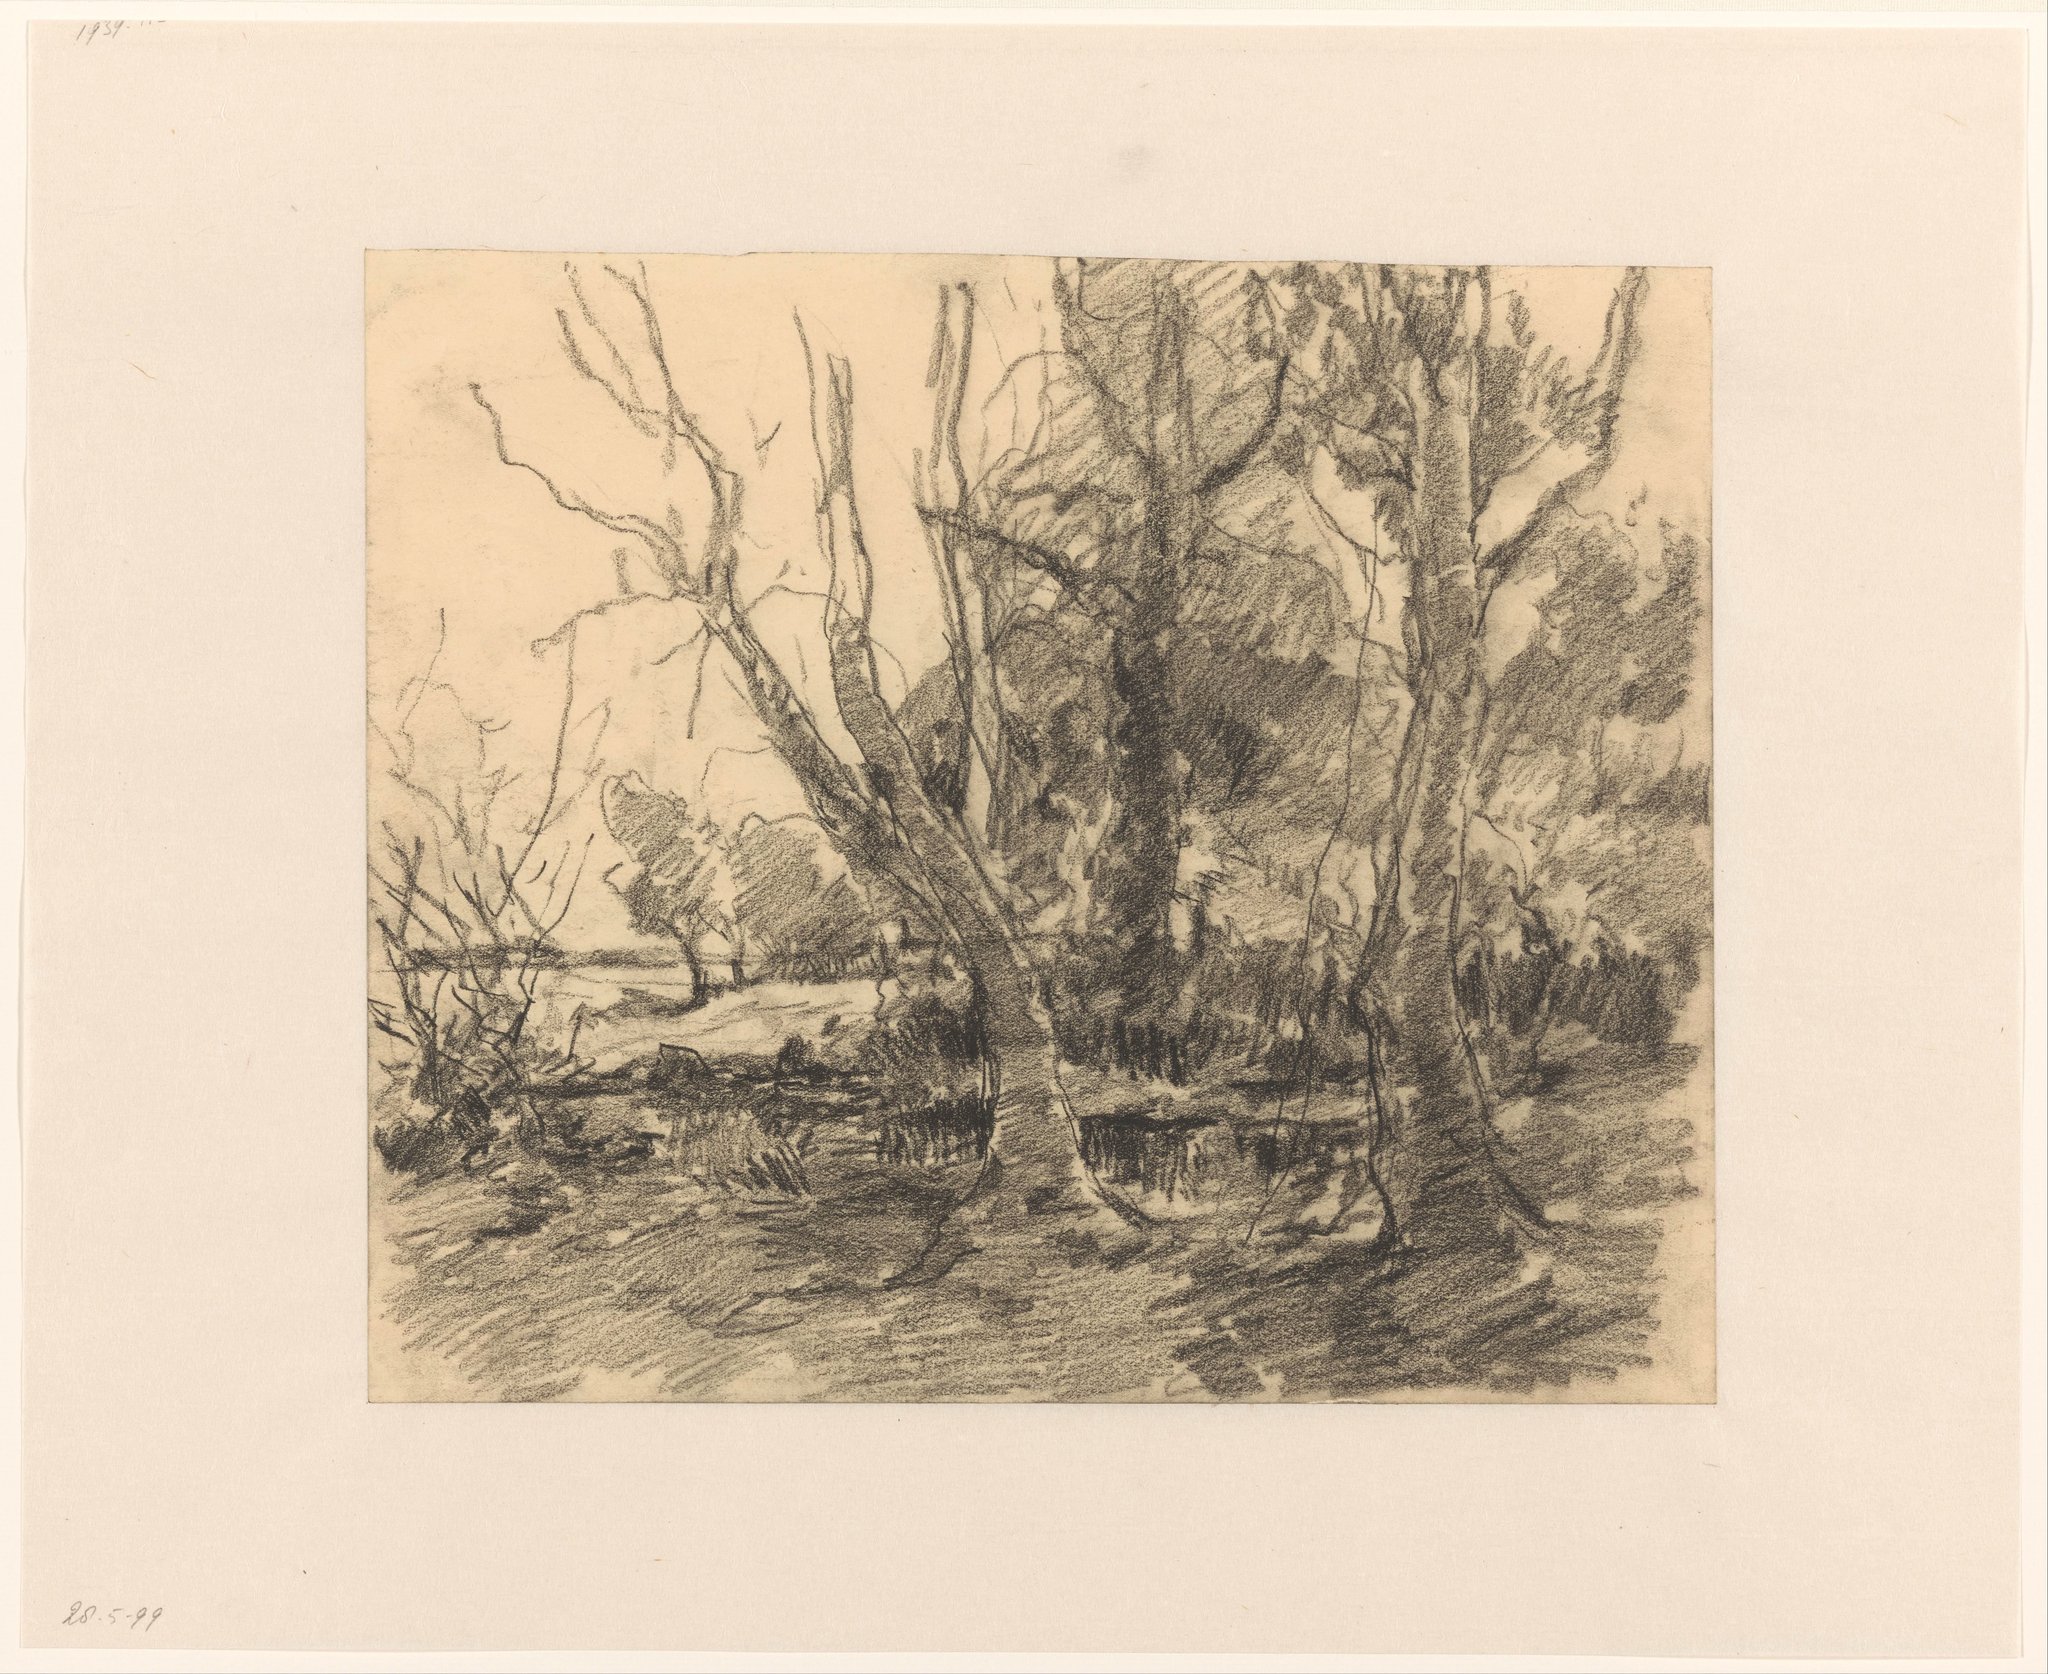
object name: drawing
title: Landschap met bomen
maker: egbert rubertus derk schaap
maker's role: draughtsman, painter, print maker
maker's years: 1862-1939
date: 1872-1939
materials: chalk, paper